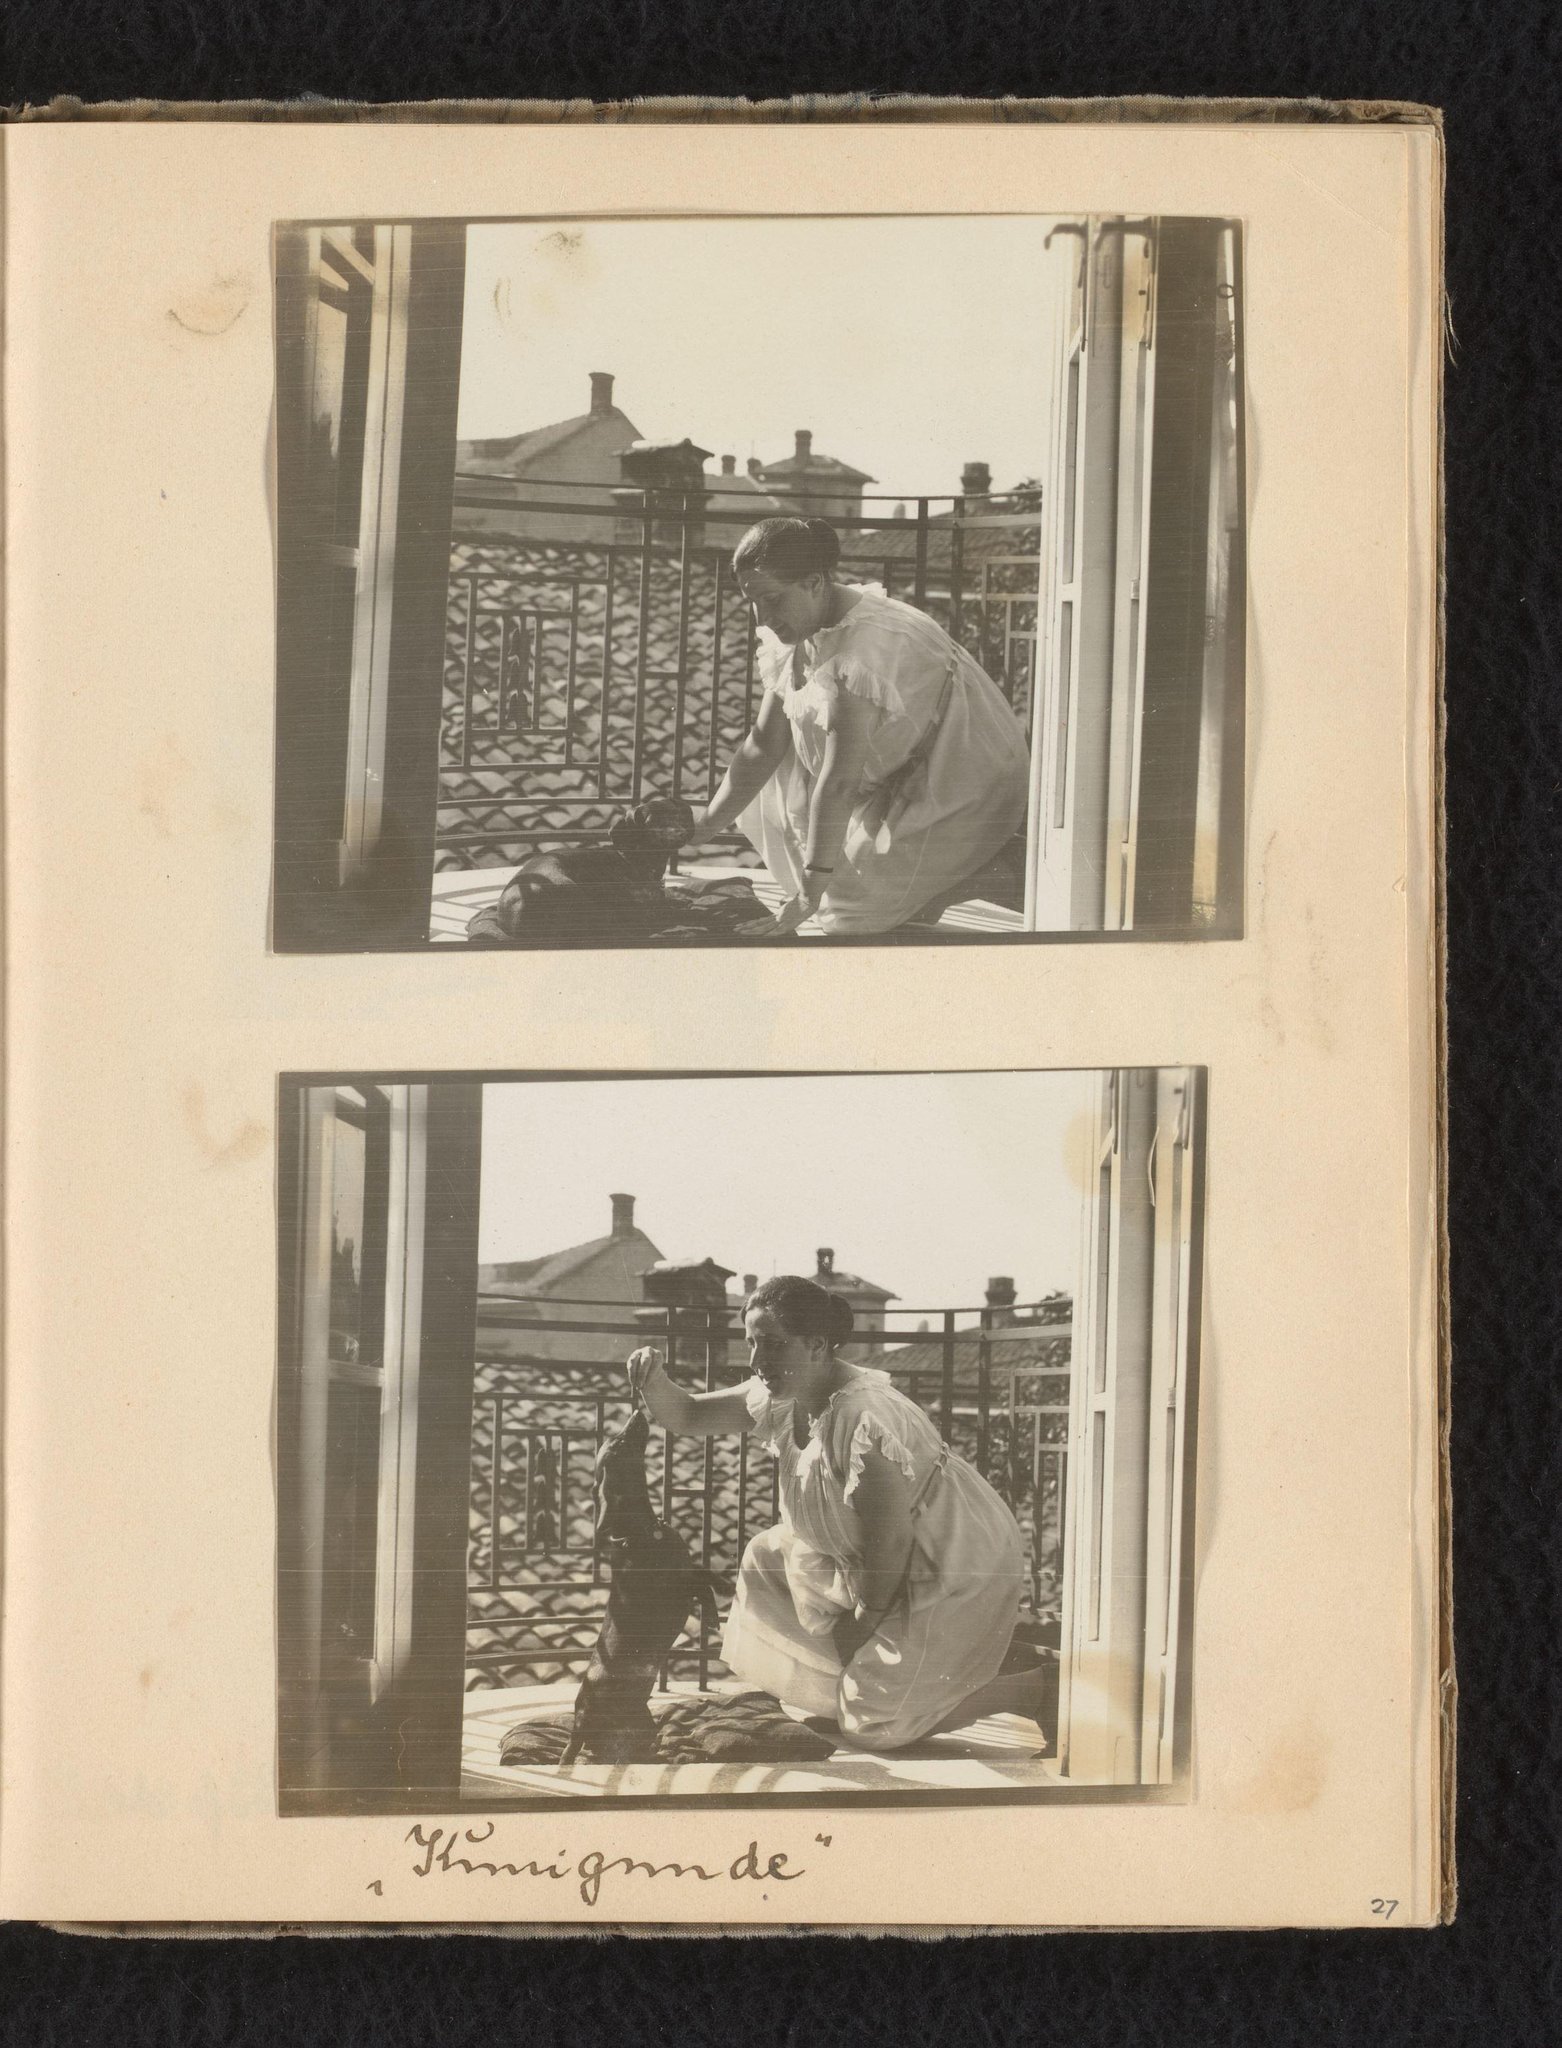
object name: album leaf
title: Else Wachenheimer-Moos speelt met haar hond op het balkon, 1927, Sofia/Bulgarije?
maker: else wachenheimer-moos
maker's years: 1895-1944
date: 1927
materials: paper, photographic support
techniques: gelatin silver print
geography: bulgaria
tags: else wachenheimer-moos, the family travelling, on holiday, dog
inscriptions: inscription: ‘,,Künnigunde"’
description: Blad bevat twee foto's van Else Wachenheimer-Moos. Onderdeel van het fotoalbum van de reizen die Eugen en Else Wachenheimer jaarlijks maakten rondom de viering van hun huwelijksdag en verloving.